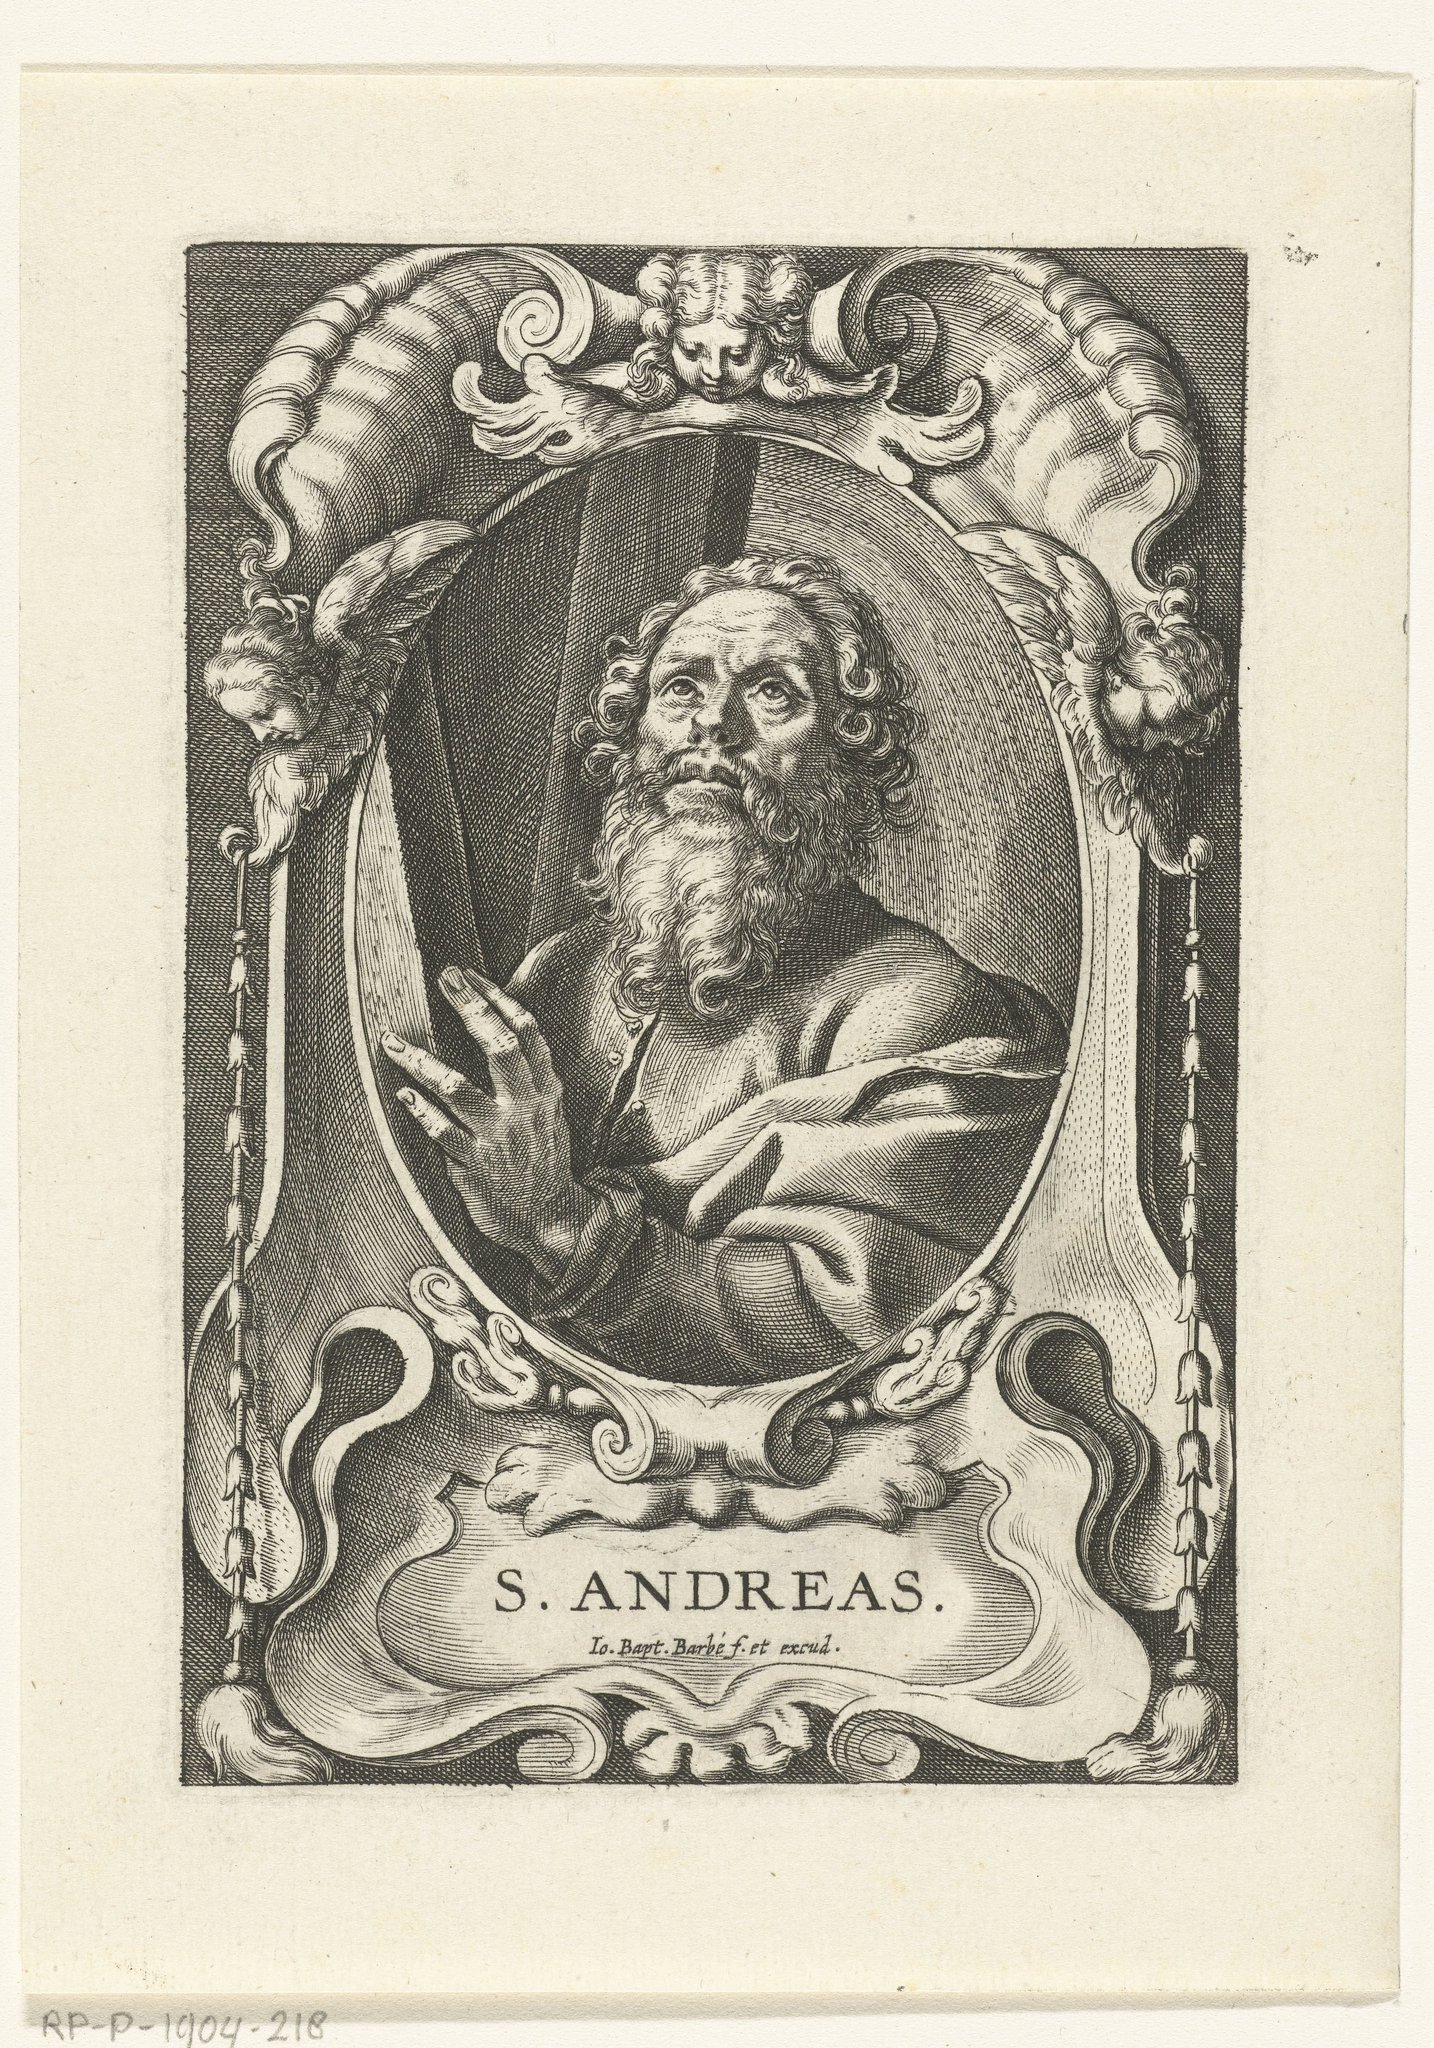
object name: print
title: Apostel Andreas met kruis in omlijsting met architectuur ornamenten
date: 1588-1648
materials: paper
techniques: engraving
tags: the apostle andrew; possible attributes: book, x-shaped cross, fish, fishing-net, rope, scroll, ornament derived from architectural details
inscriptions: collector's mark: Lugt 2228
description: Prent uit: SS. Apostolorum et Evangelistorum Icones, Jean Baptiste Barbé (uitgever). Prent naar tekening van Nicolaas van der Horst.